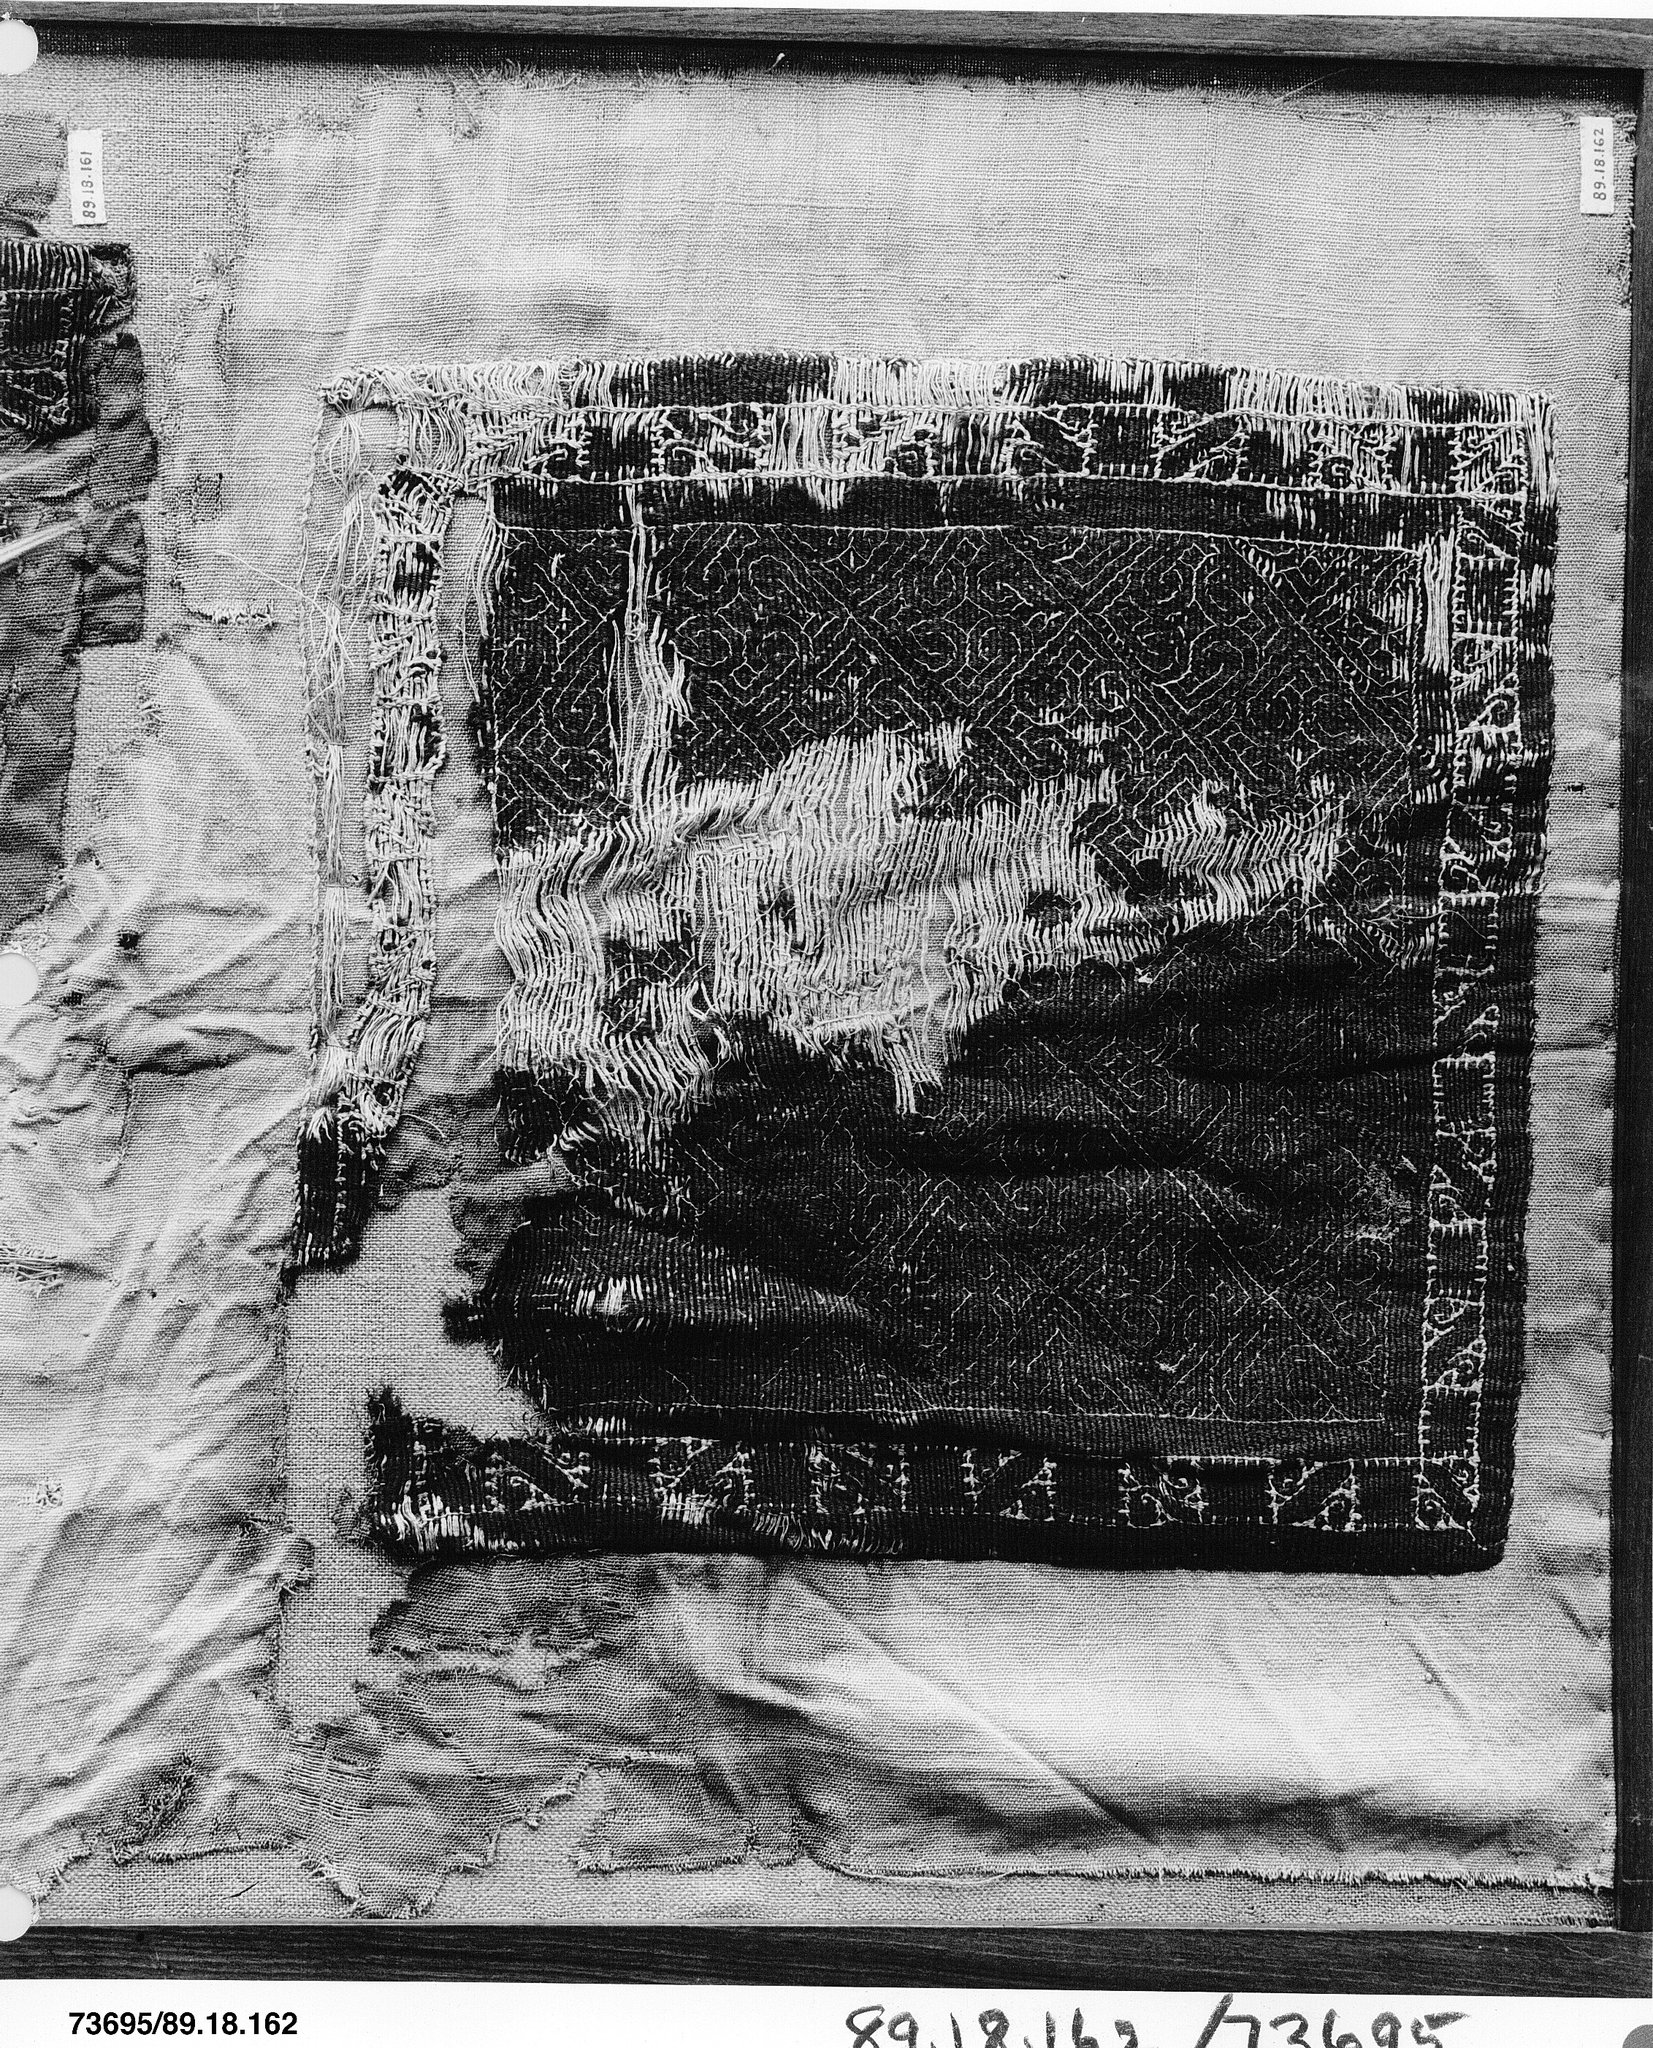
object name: textile fragment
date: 201-400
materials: linen, wool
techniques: weave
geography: egypt